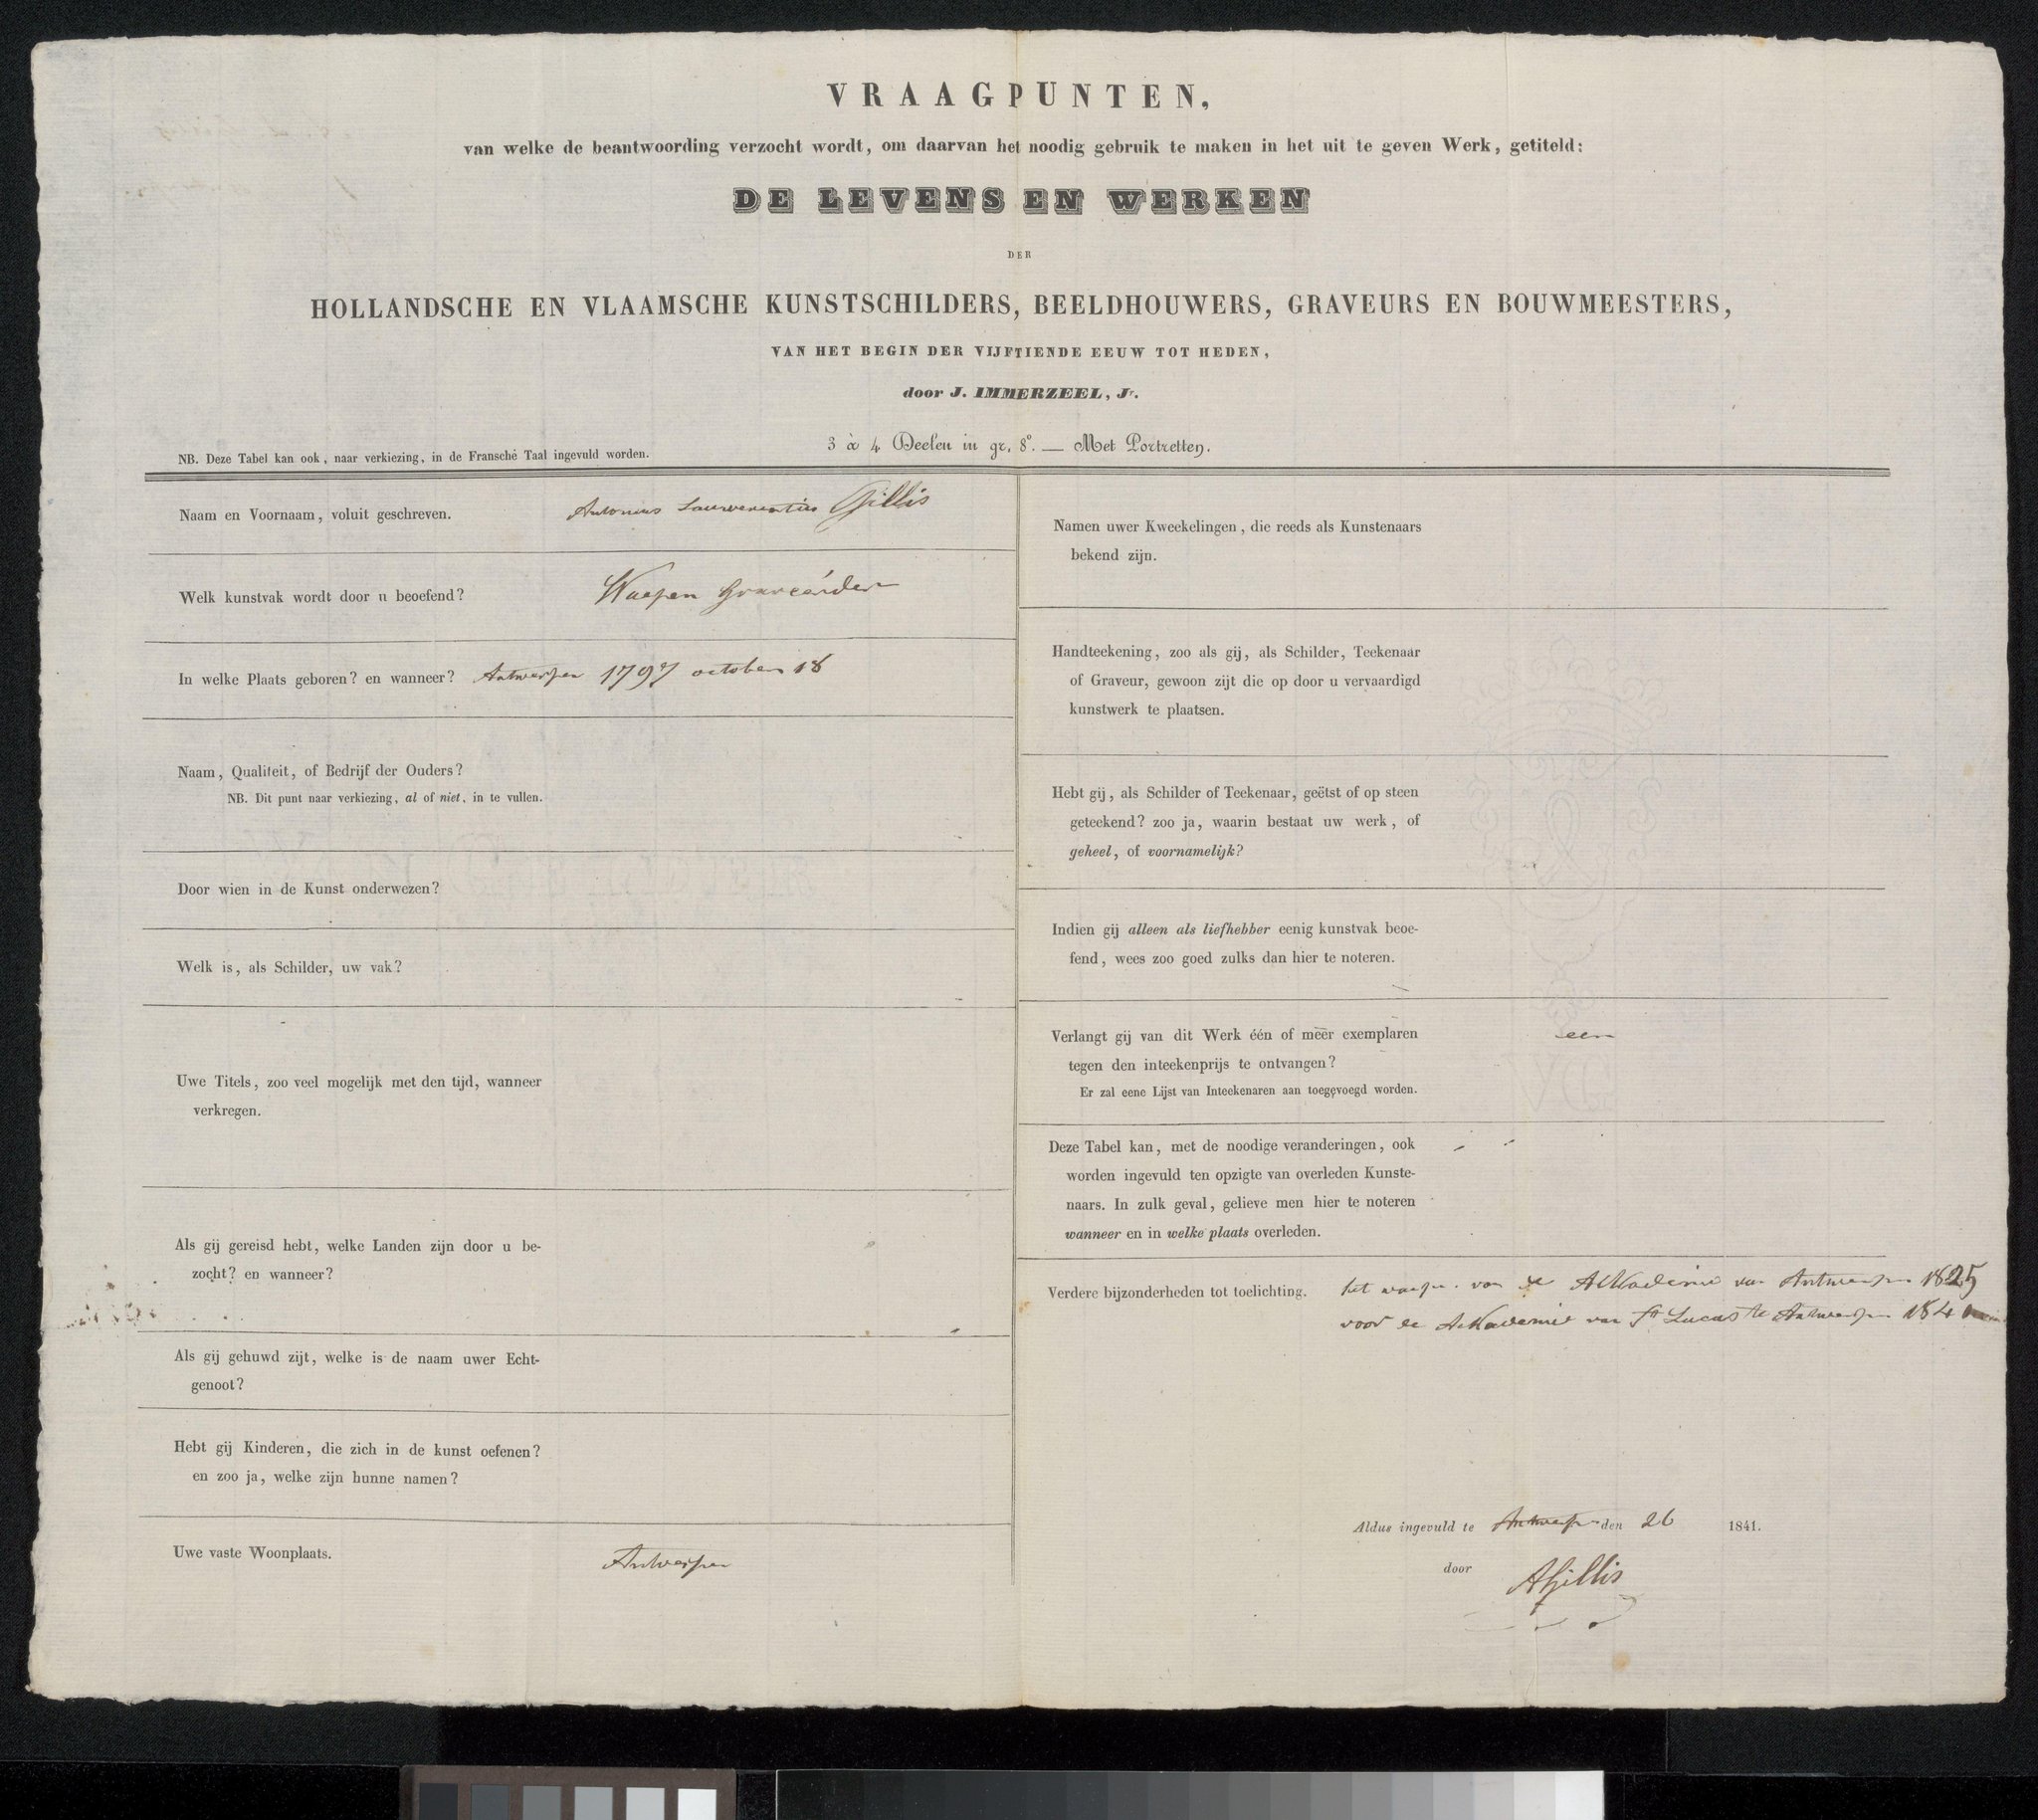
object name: manuscript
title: Enquêteformulier ingevuld door Antonius Laurentius Gilles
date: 1841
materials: ink, paper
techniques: pen, printing, writing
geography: antwerp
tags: die cutter, antonius laurentius gilles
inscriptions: inscription: ‘Vraagpunten,/ van welke de beantwoording verzocht wordt, om daarvan het noodig gebruik te maken in het uit te geven Werk, getiteld: De levens en werken/ der Hollandsche en Vlaamsche kunstschilders, beeldhouwers,/ graveurs en bouwmeesters, van het begin der vijftiende eeuw tot heden/ door J. Immerzeel, Jr.’, watermark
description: Opgenomen in: Immerzeel, J. Jr., De levens en werken der Hollandsche en Vlaamsche kunstschilders, beeldhouwers, graveurs en bouwmeesters, van het begin der vijftiende eeuw tot heden, Amsterdam: J.C. van Kesteren, 1842-1843.